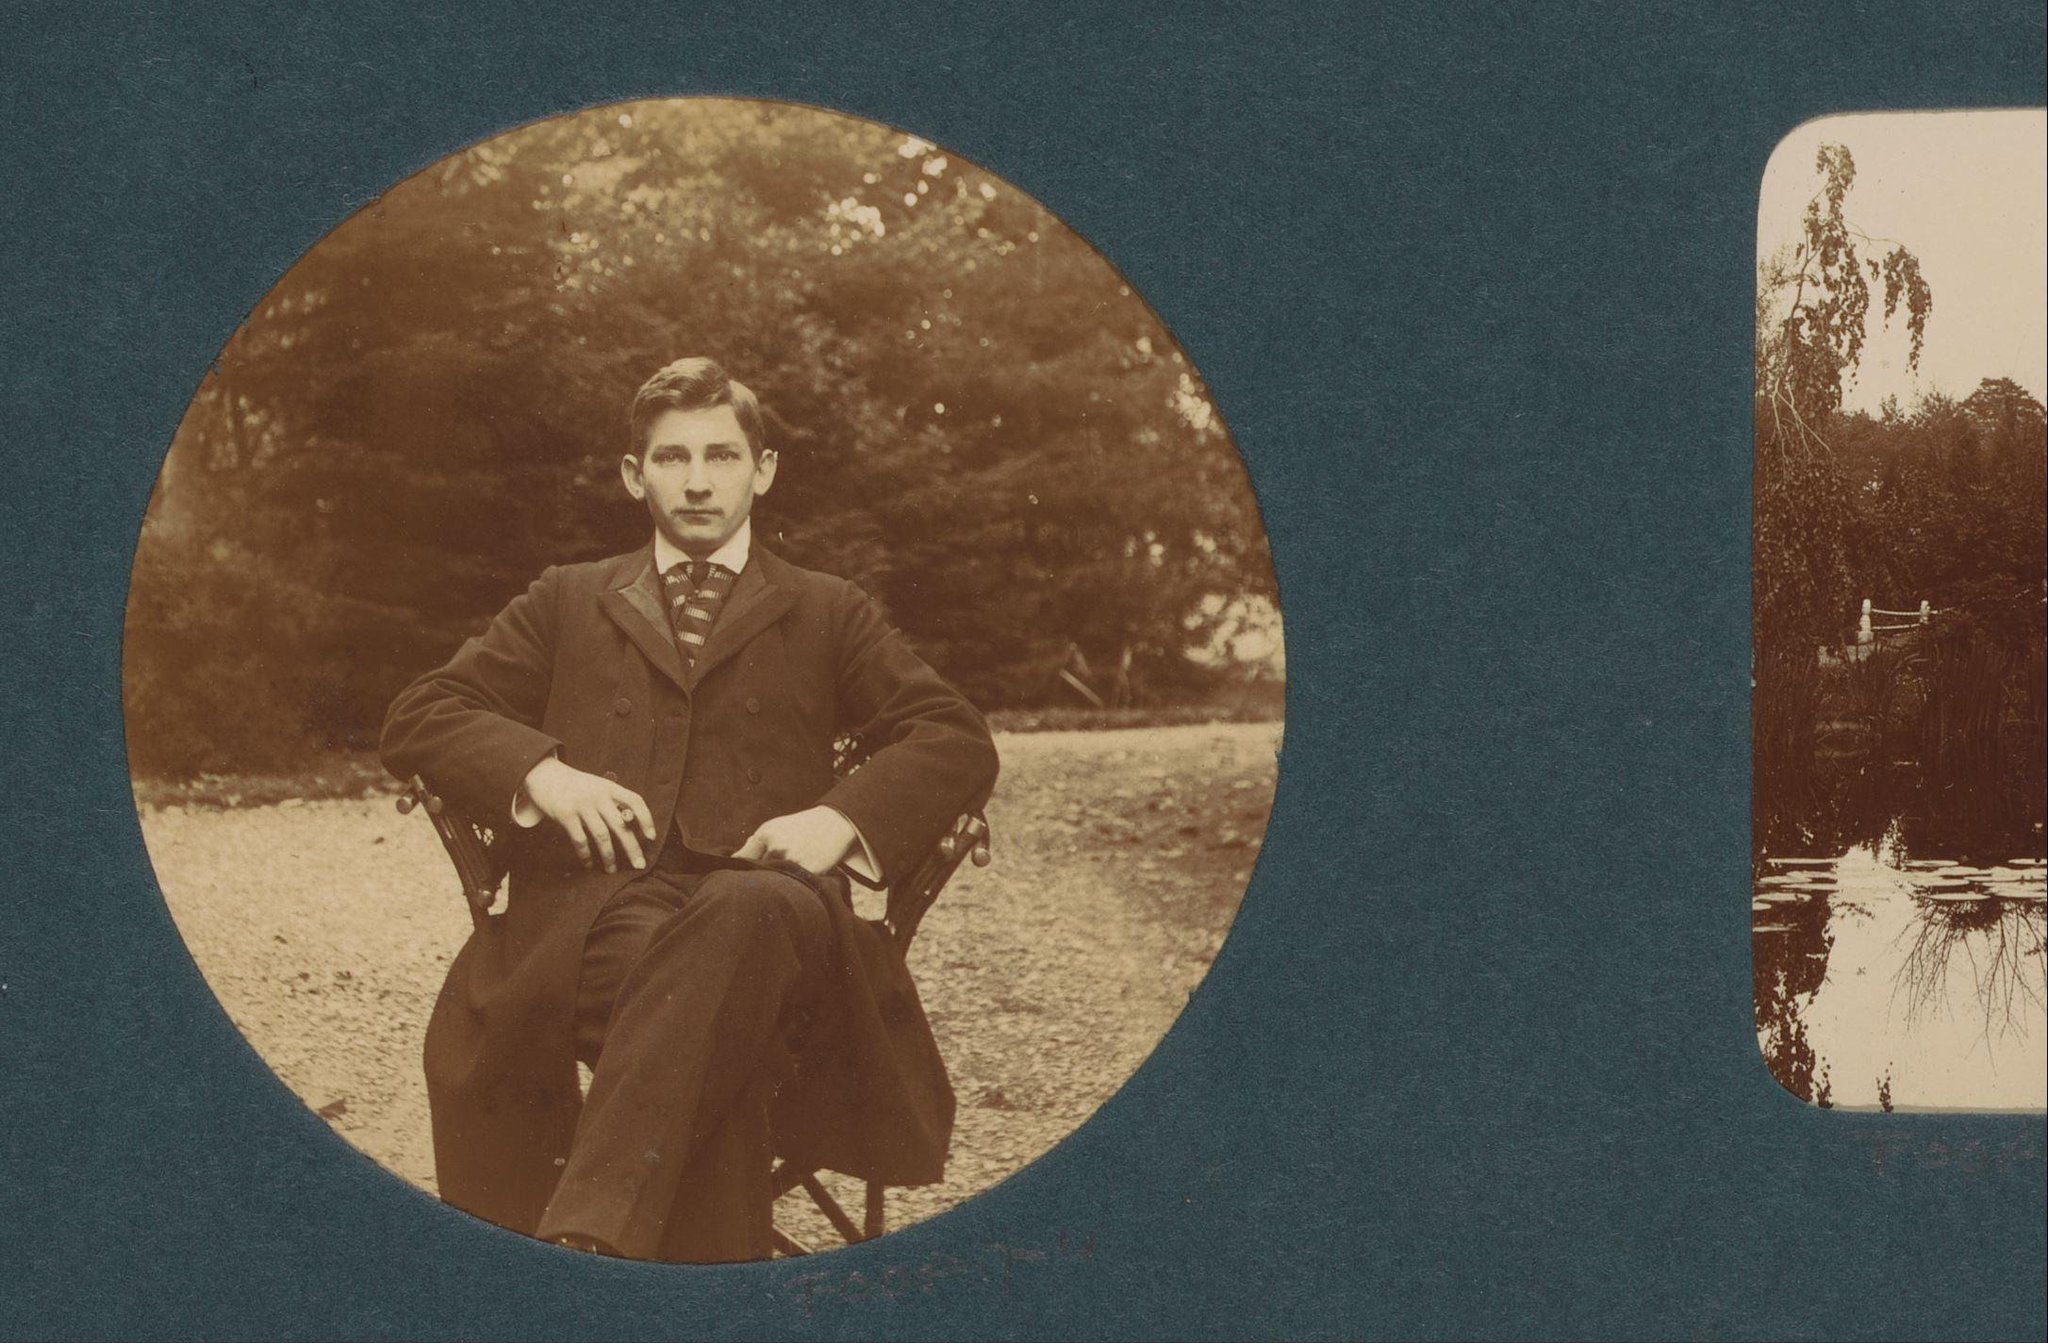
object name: photograph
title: Portret van een jongeman, zittend in de buitenlucht, vermoedelijk in Nederland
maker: Anonymous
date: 1902-1906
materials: cardboard, paper, photographic support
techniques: gelatin silver print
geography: netherlands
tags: youth, adolescent, netherlands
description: Onderdeel van Reisalbum van een Nederlandse familie met bezienswaardigheden in Europa, Egypte en New York.